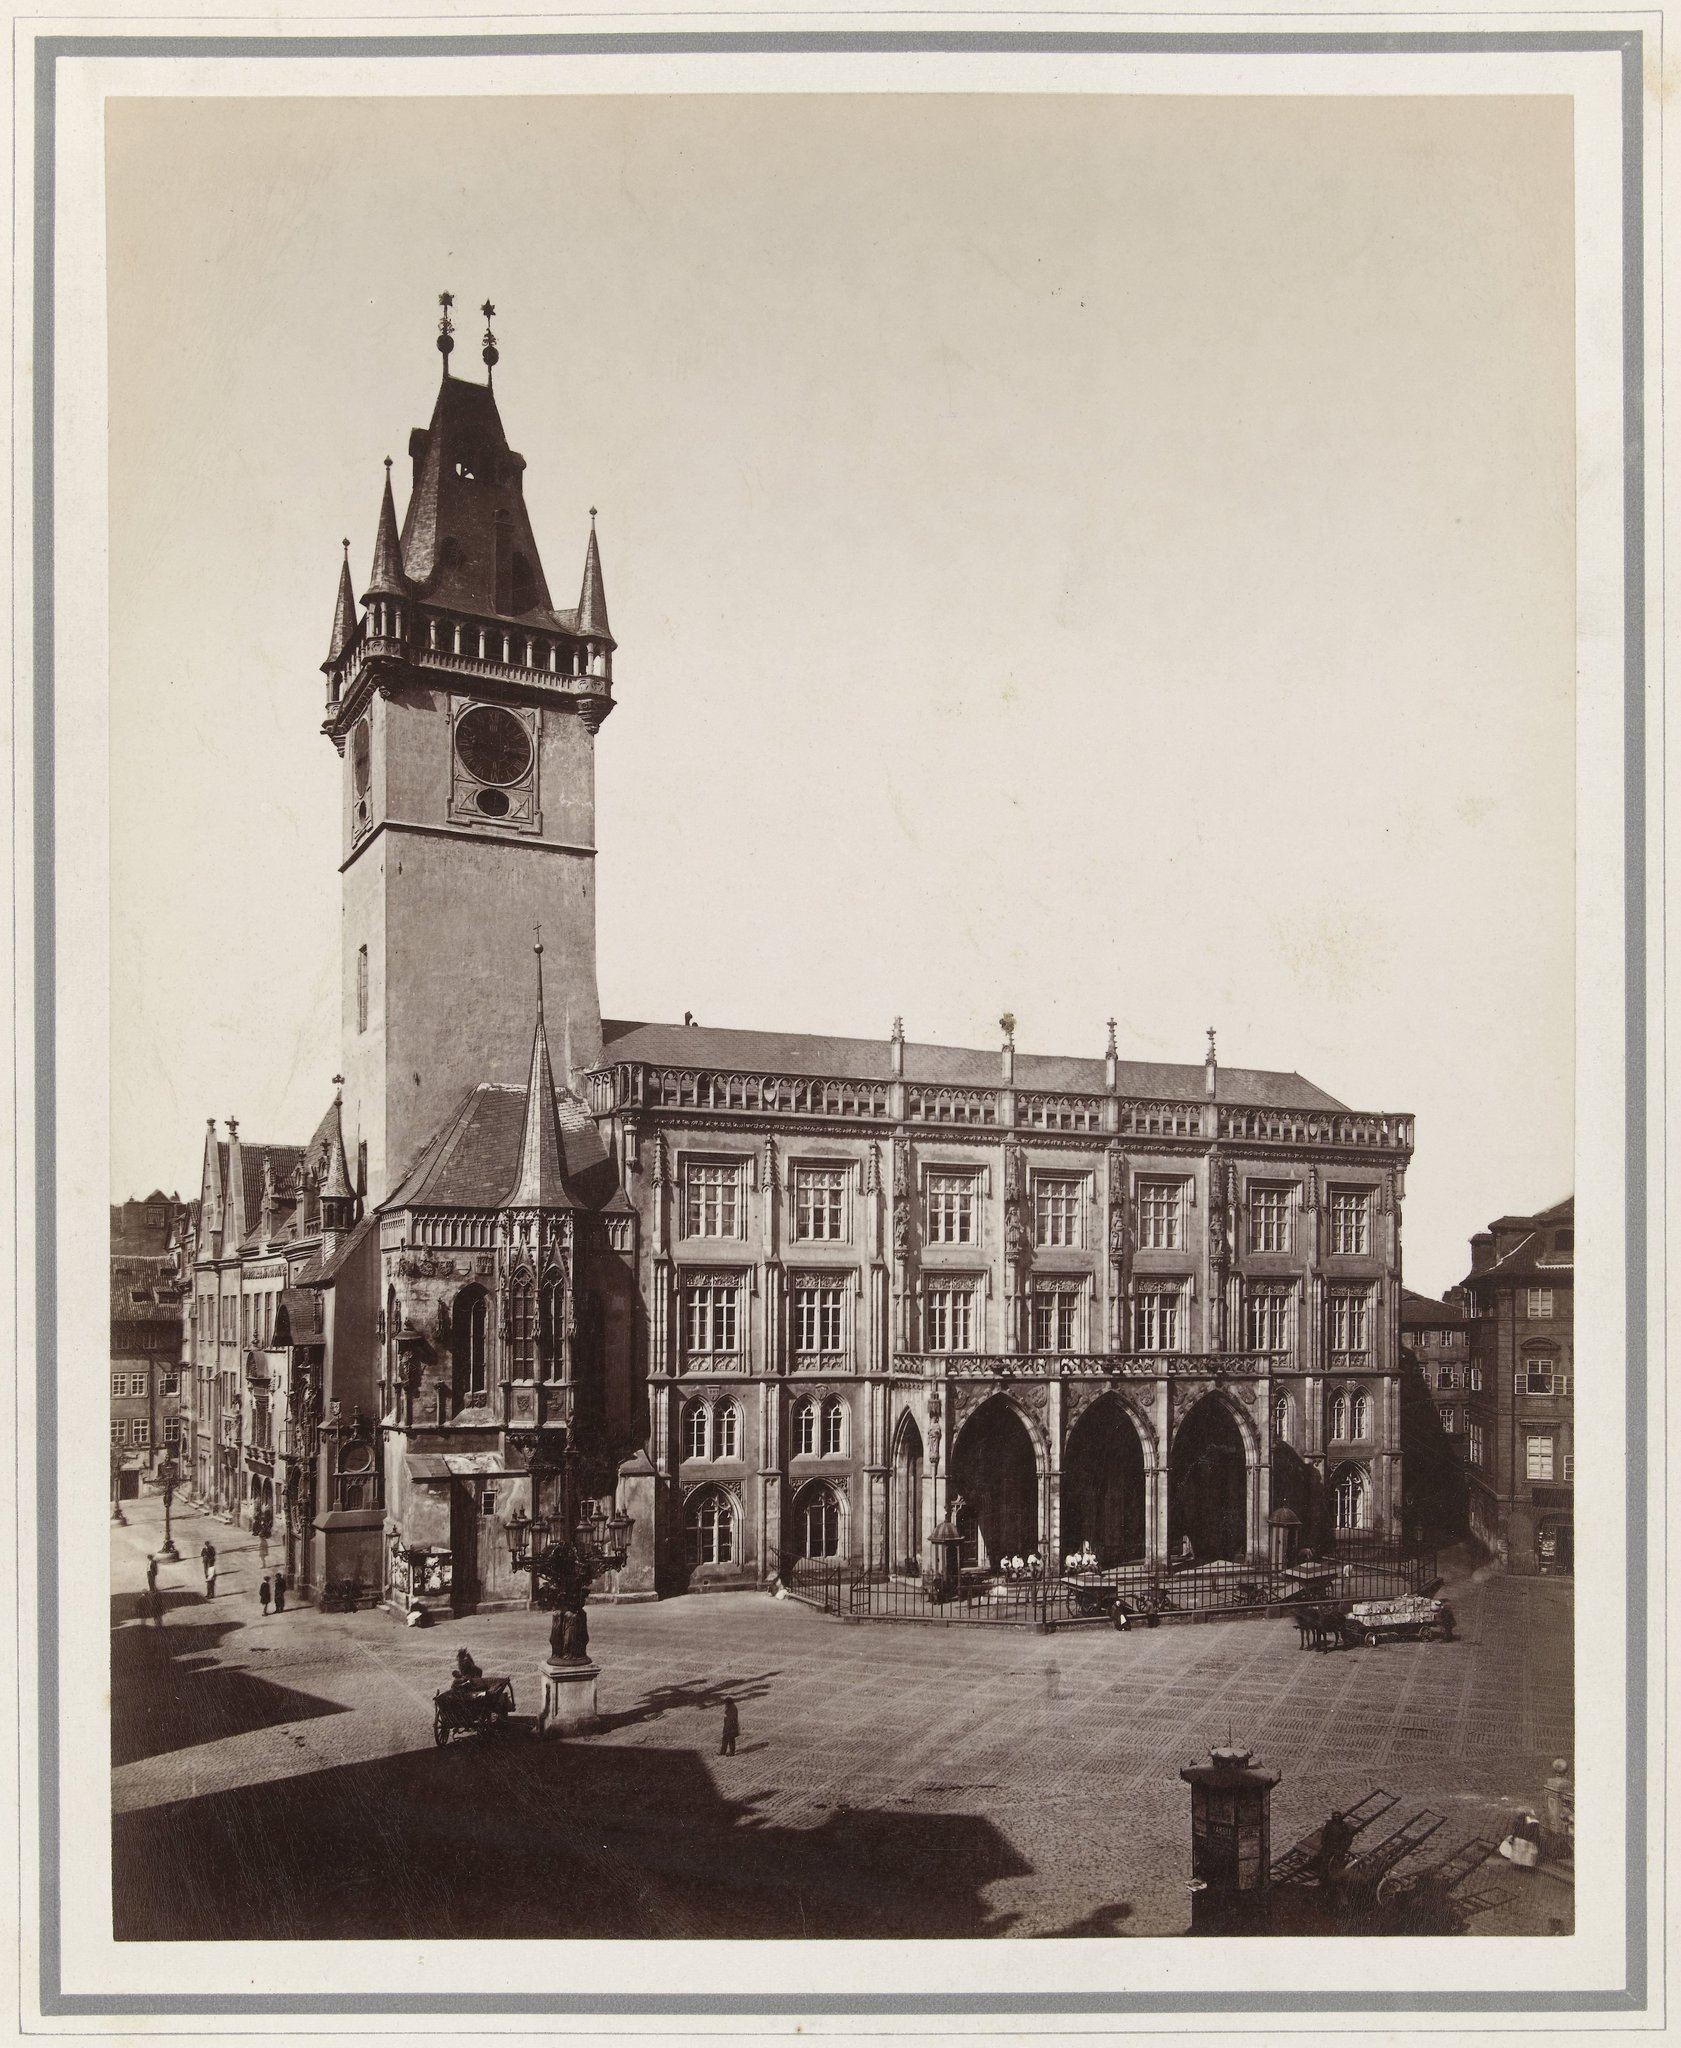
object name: photograph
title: Altstädter Rathaus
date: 1855-1900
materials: cardboard, paper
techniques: albumen print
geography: prague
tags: townhall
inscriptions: number: ‘34.’